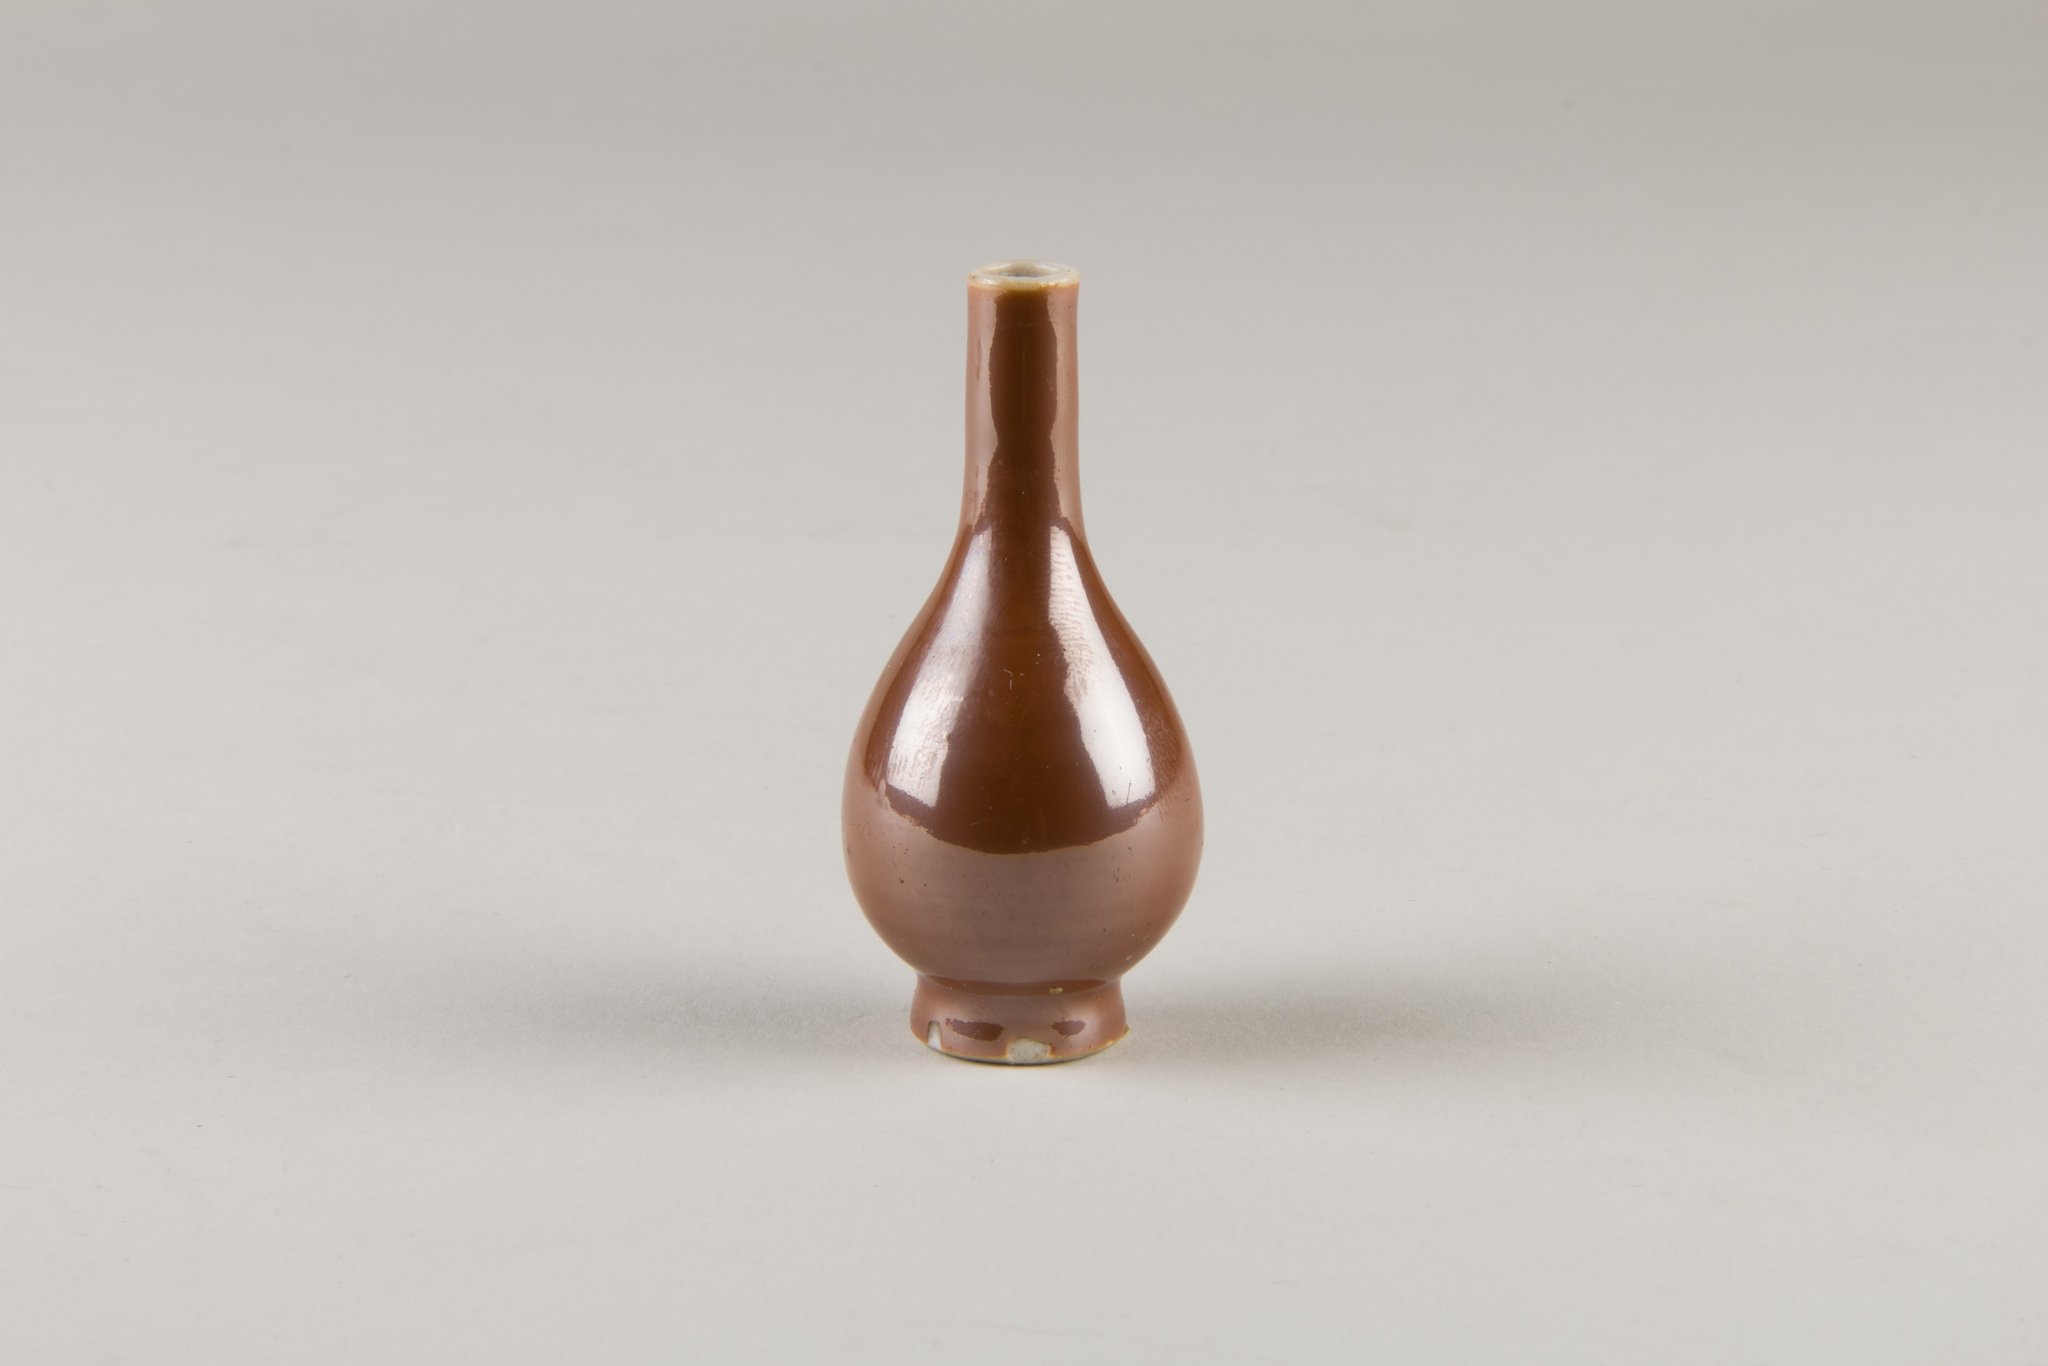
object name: bottle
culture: chinese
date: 1644-1911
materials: porcelain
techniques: painting, underglaze